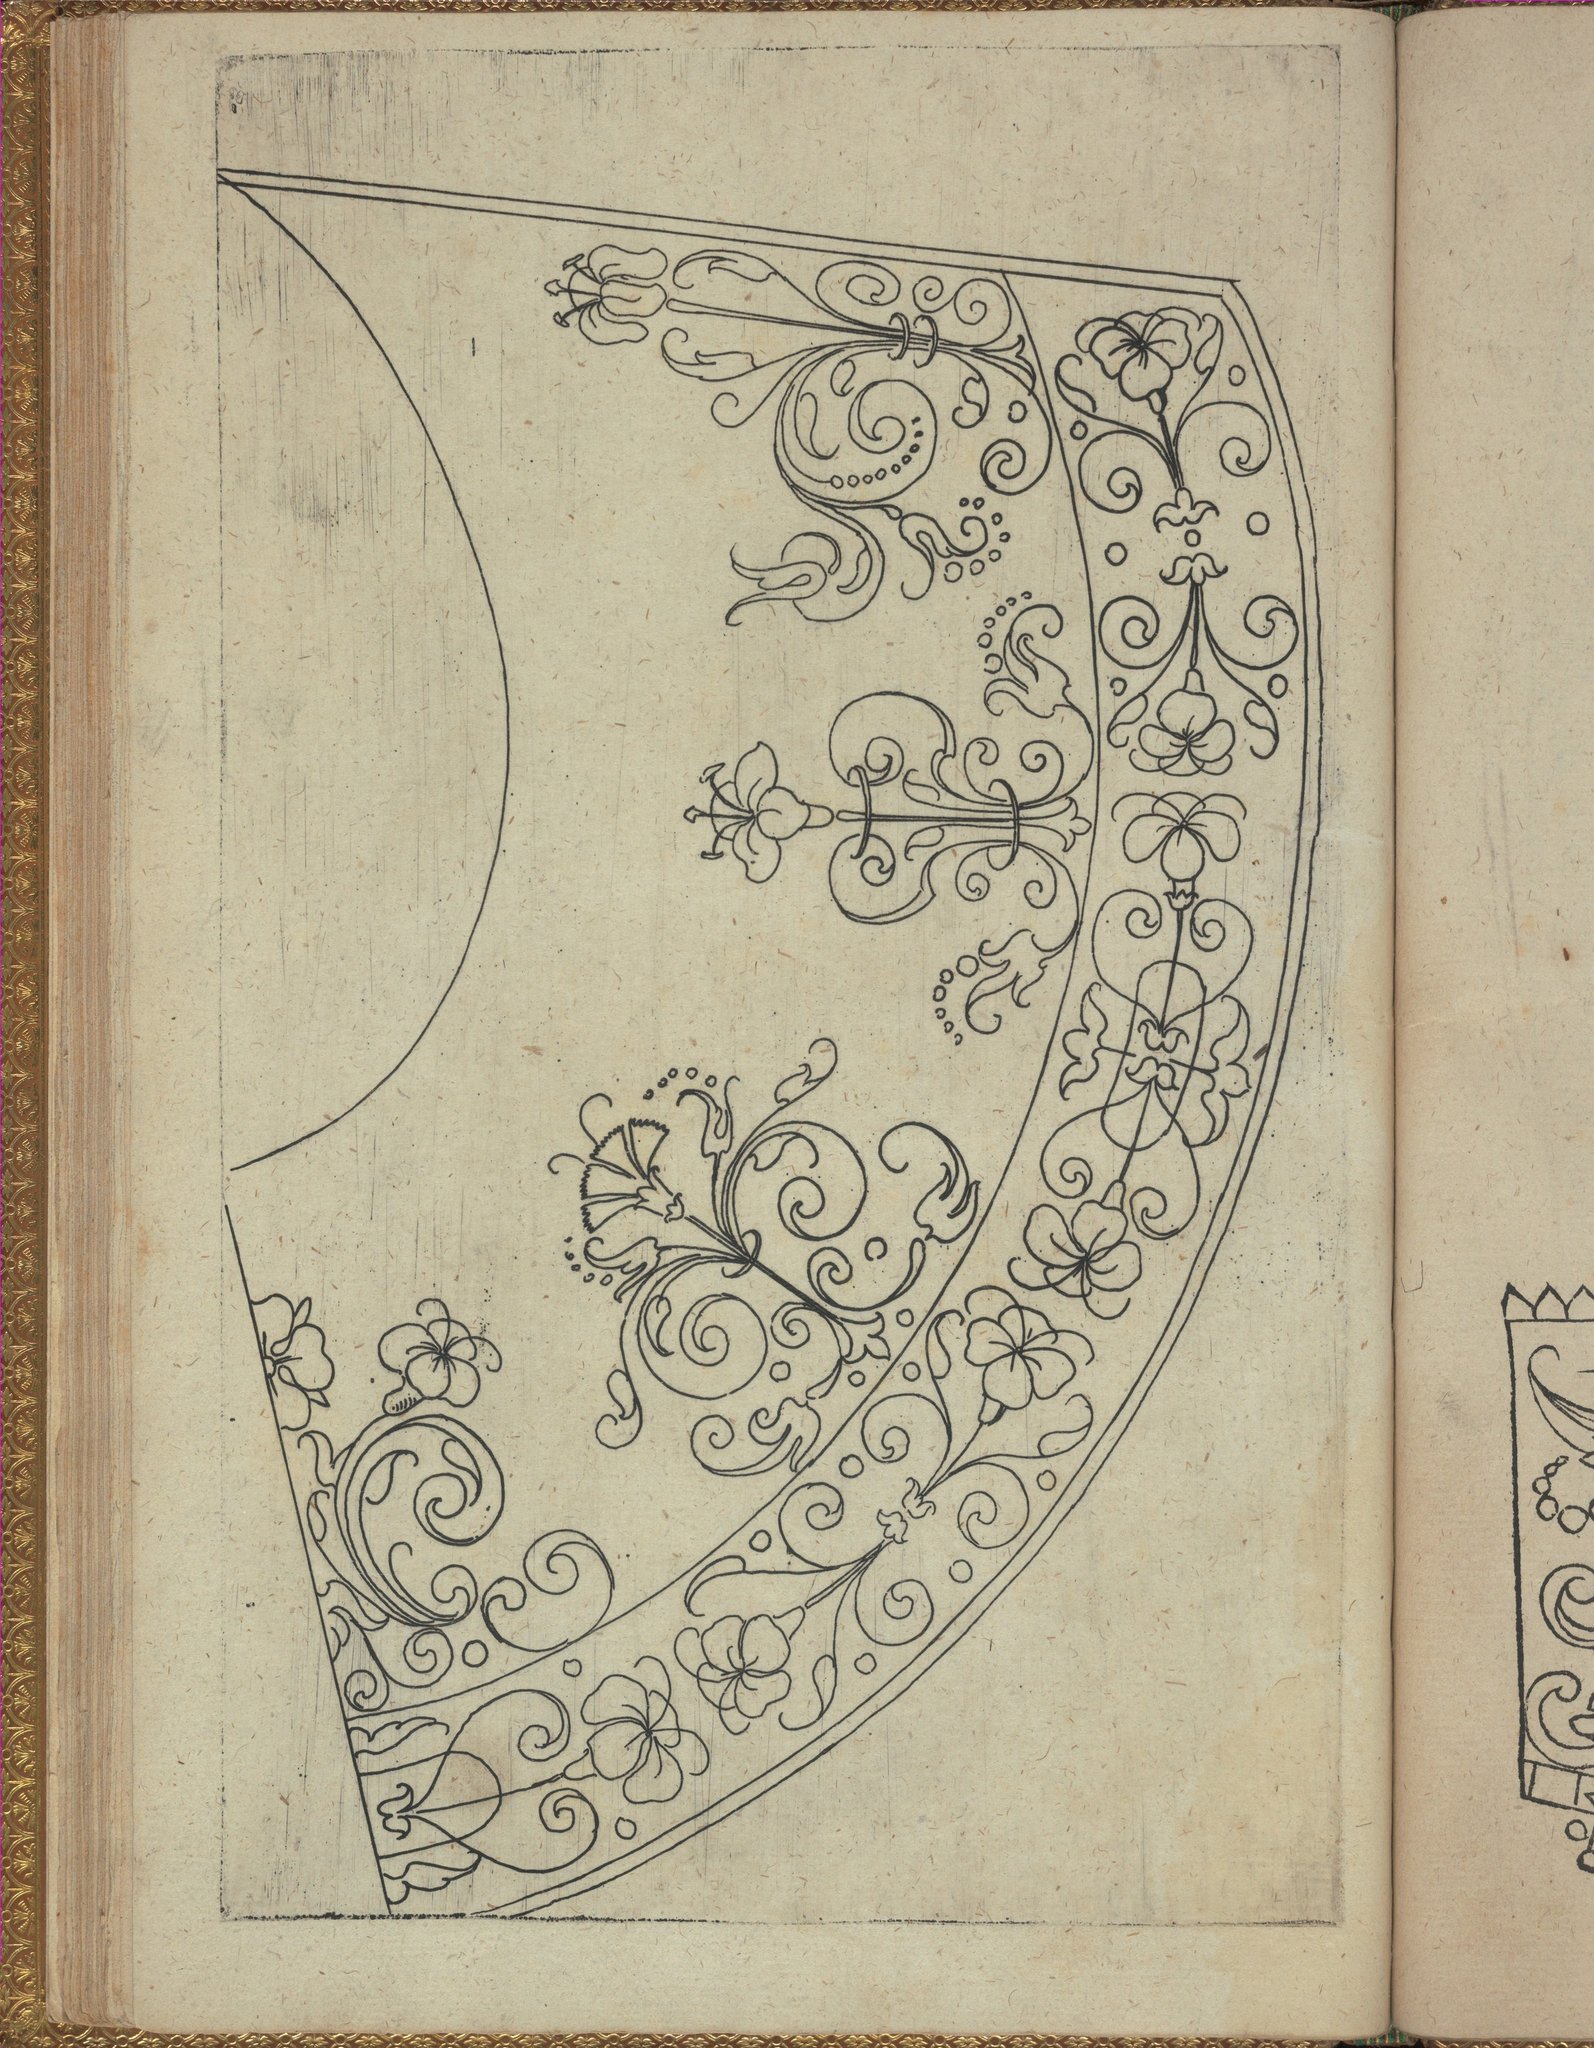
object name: book print ornament architecture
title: New Modelbüch (Page 41r)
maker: andreas bretschneider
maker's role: designer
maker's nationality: german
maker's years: 1573-1645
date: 1615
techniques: woodcut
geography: germany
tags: ornament